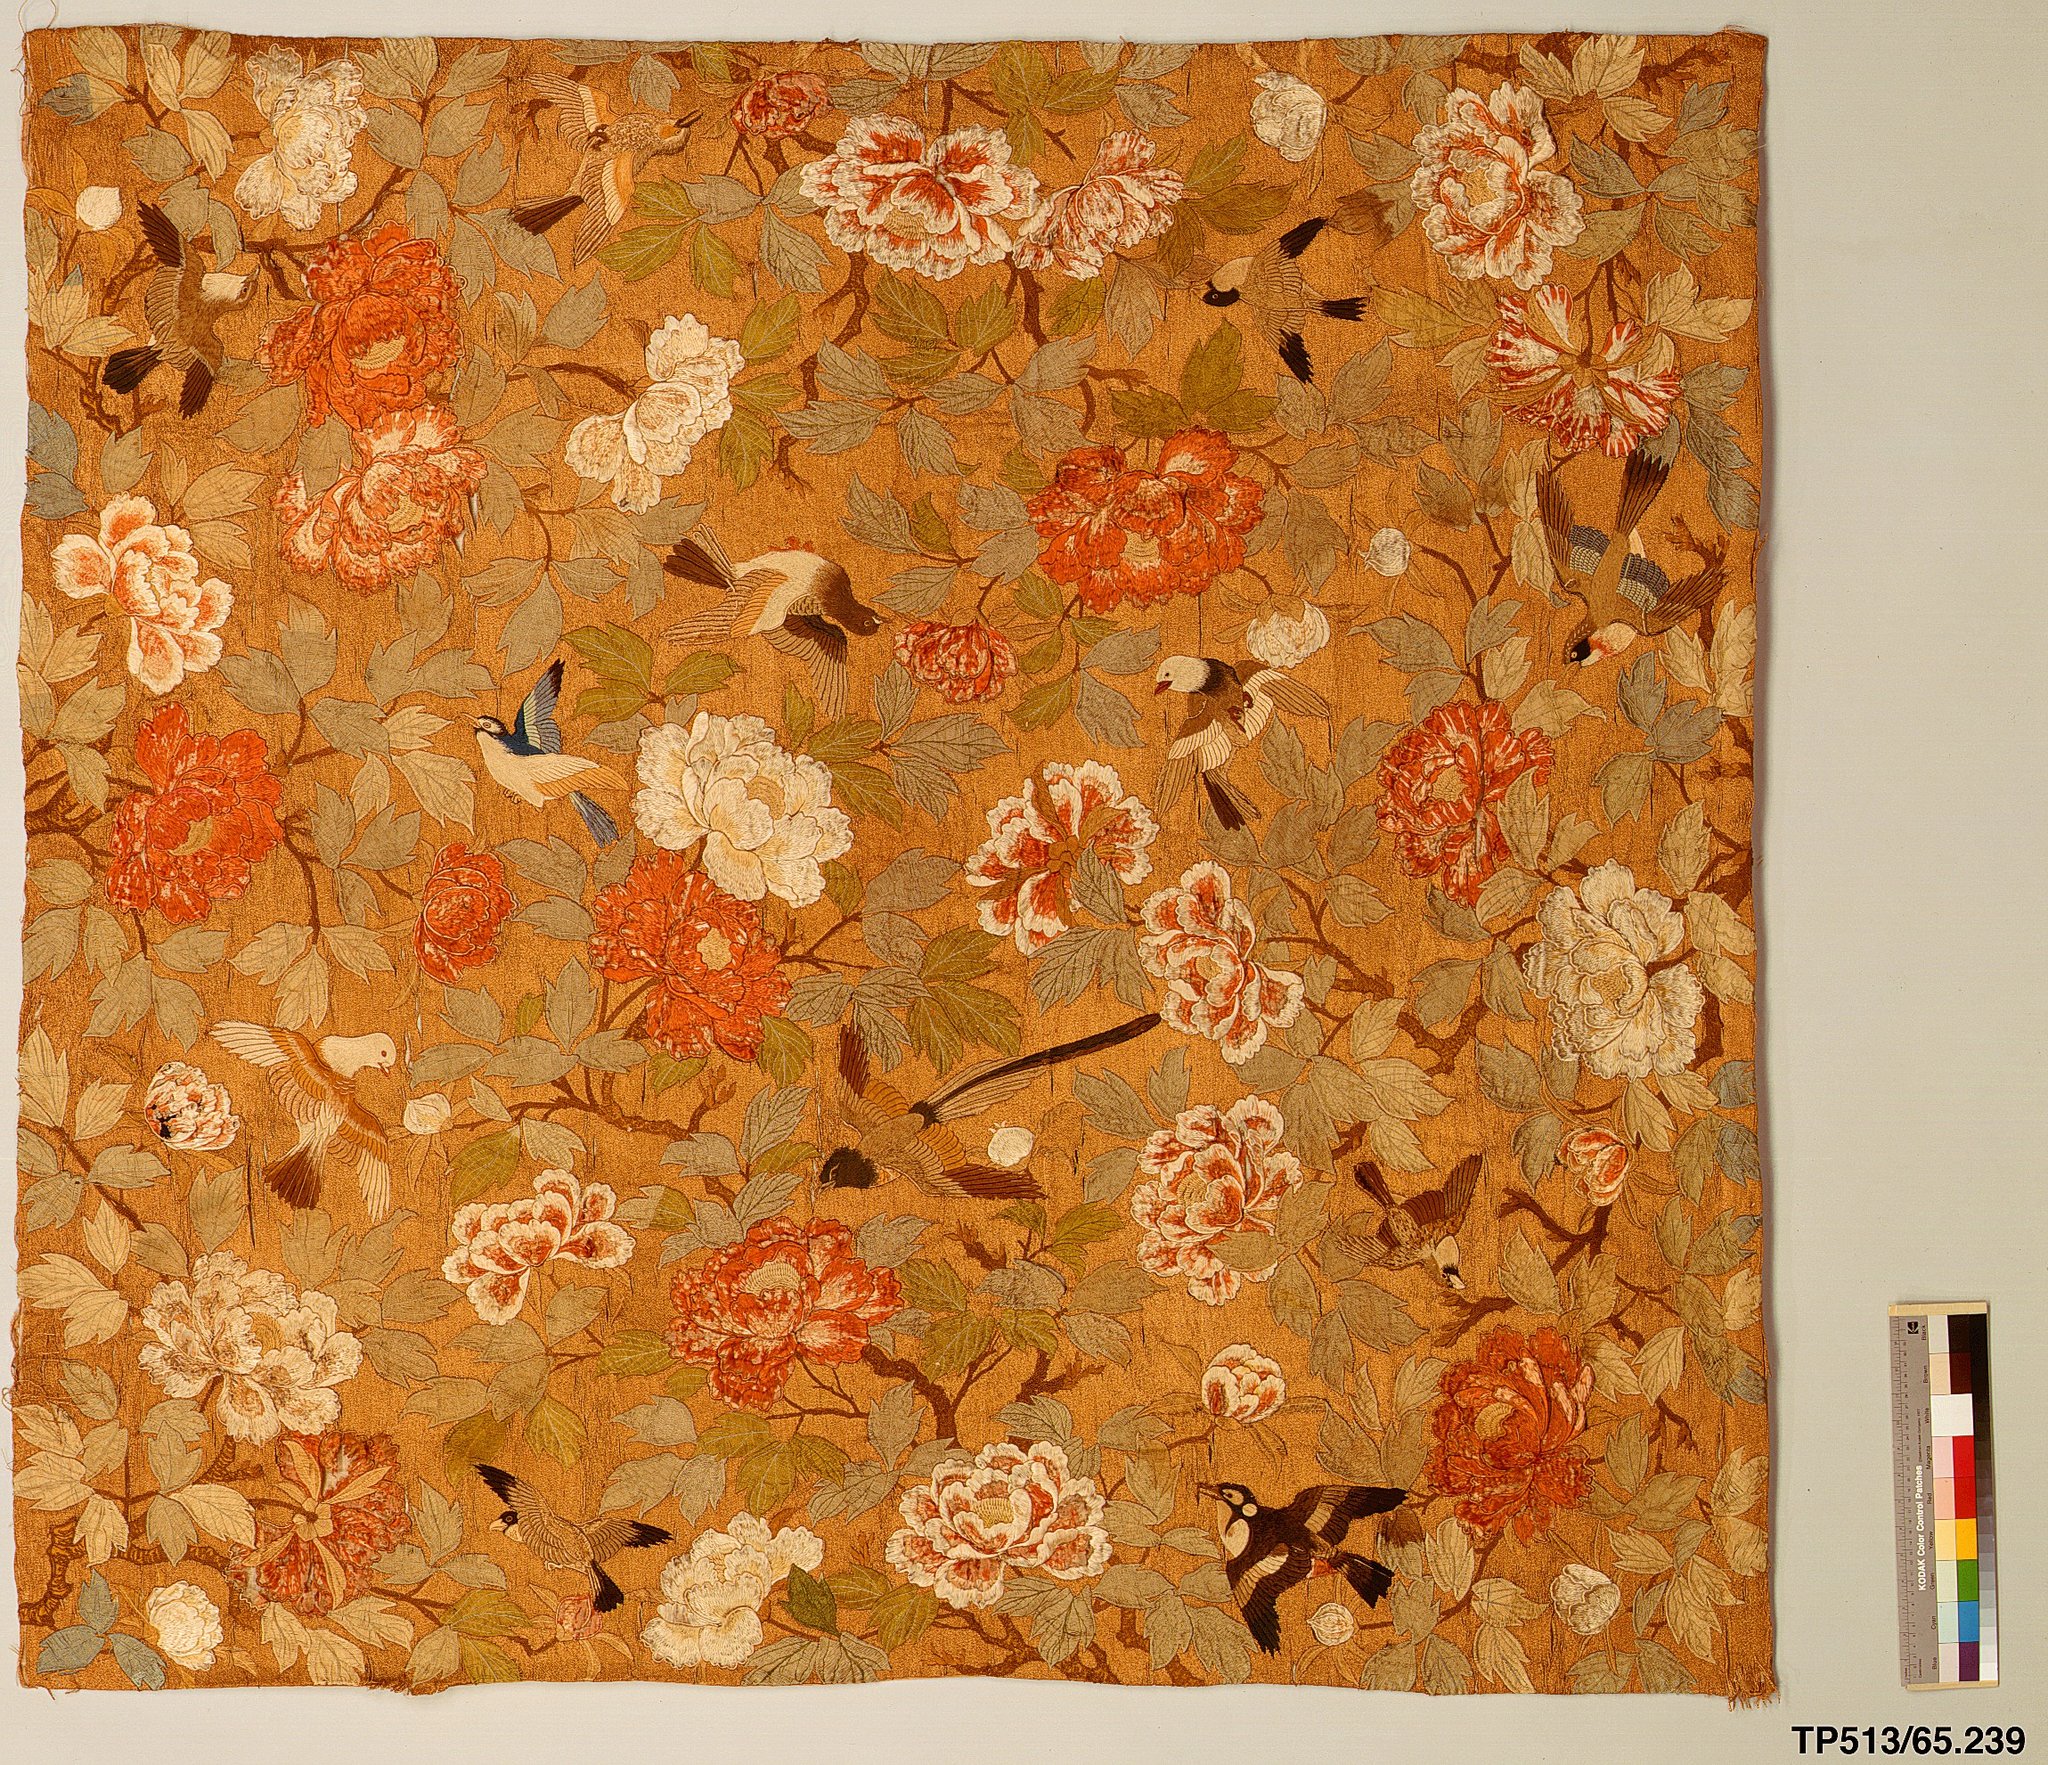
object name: panel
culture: korean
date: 1701-1800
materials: gold, paper, silk, thread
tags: flowers,leaves